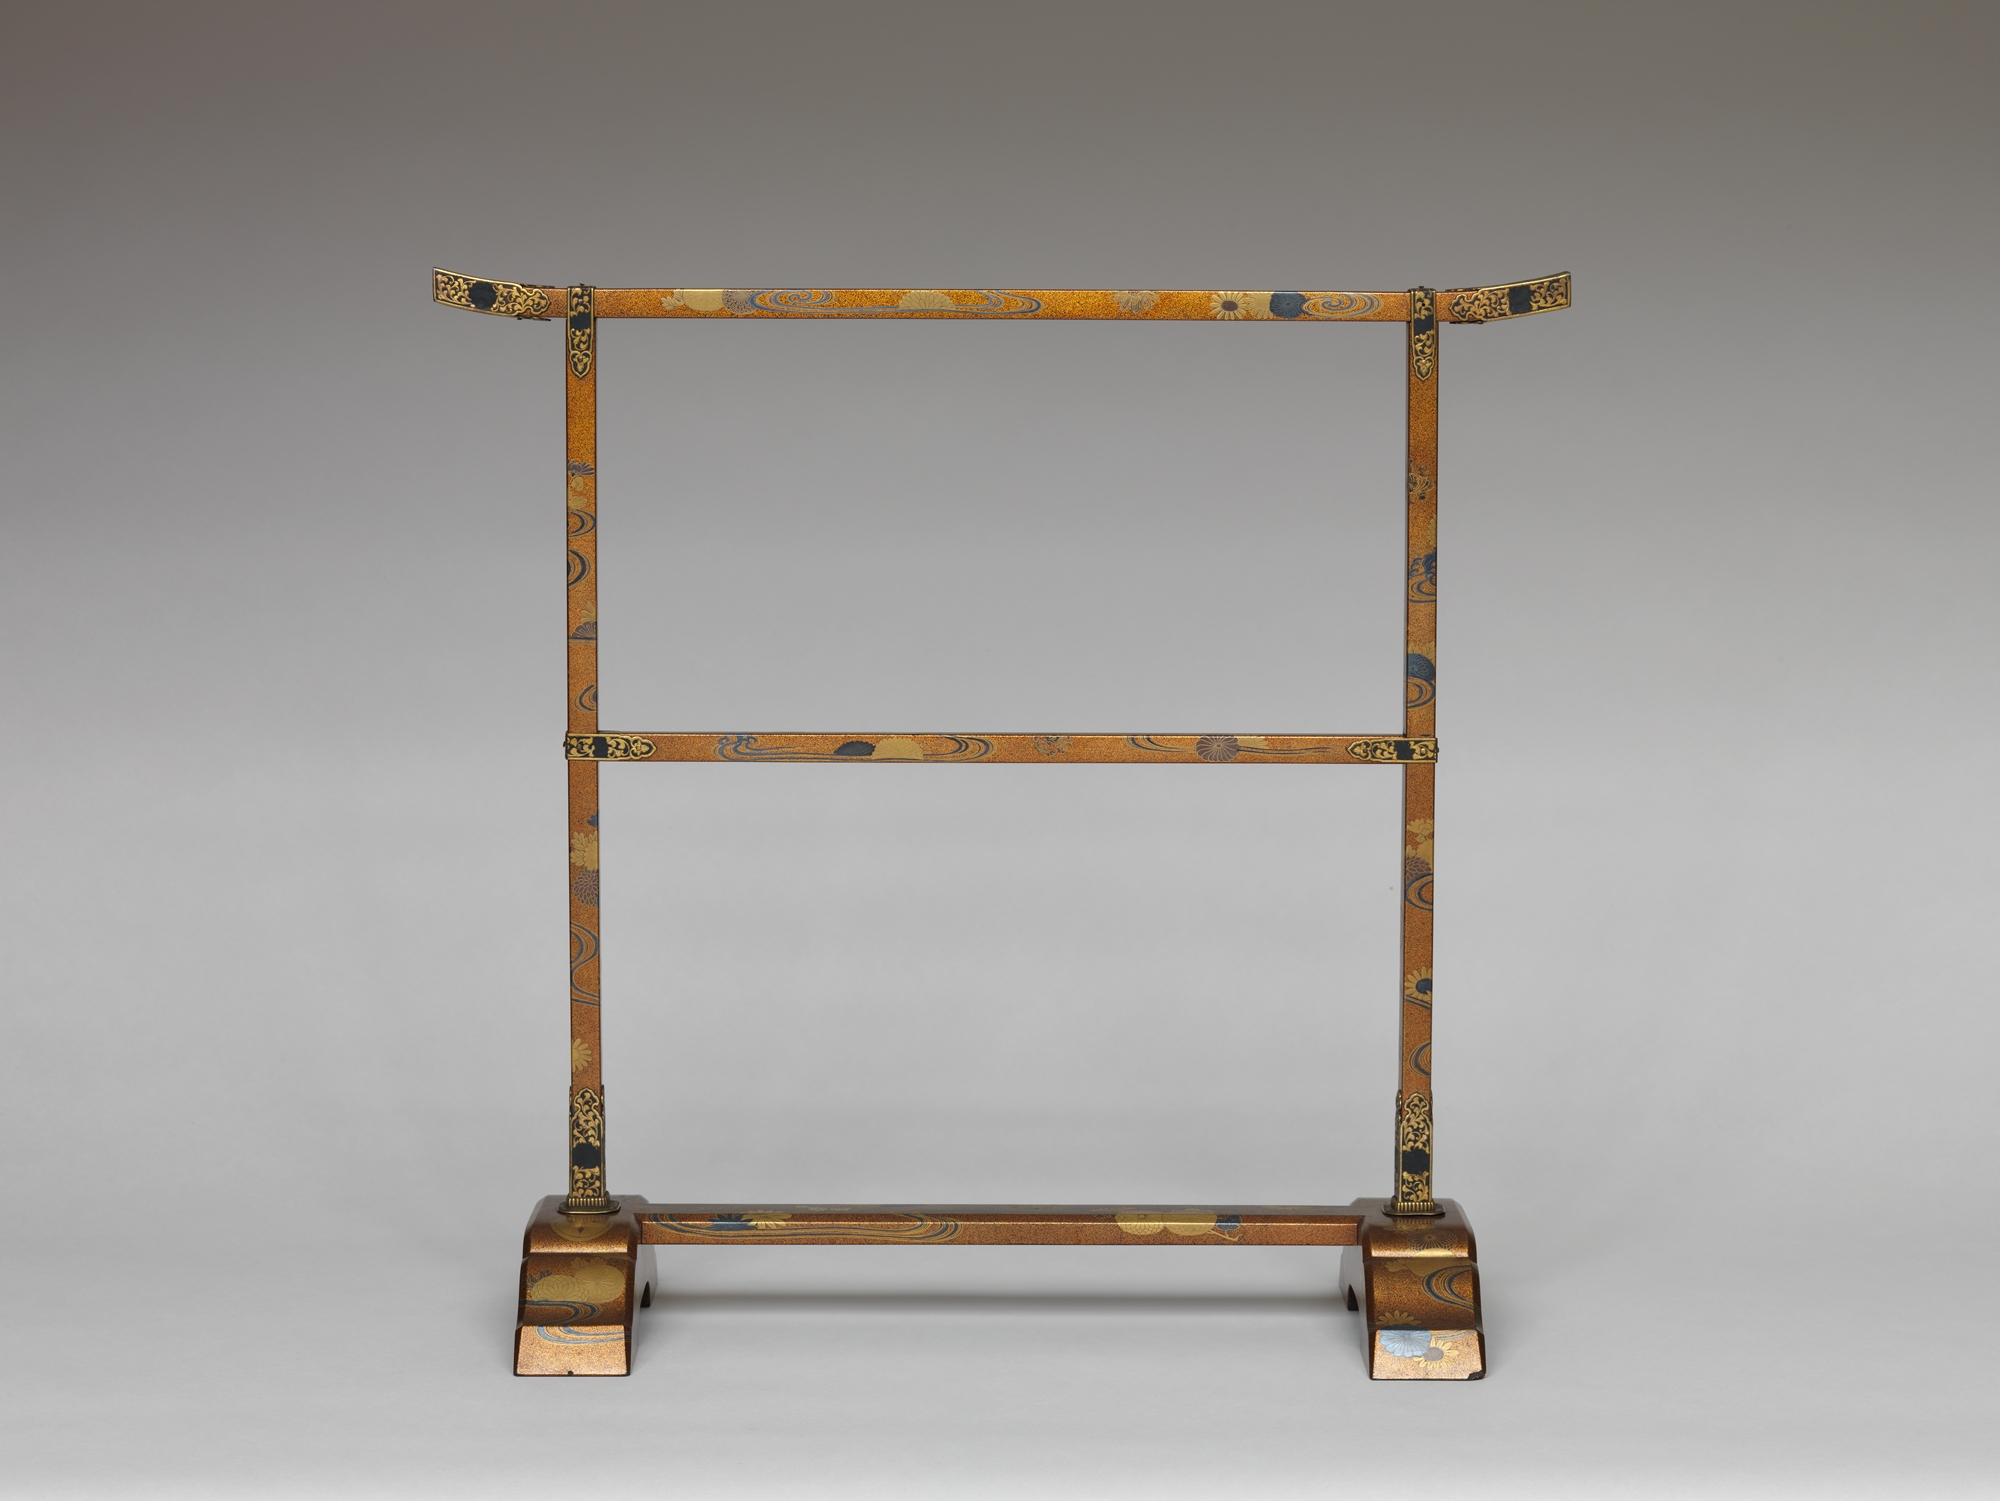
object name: robe stand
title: Hand-towel Rack (Tenugui kake) with Chrysanthemums and Meandering Stream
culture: japanese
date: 1701-1800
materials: gold, silver, wood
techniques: lacquer, maki